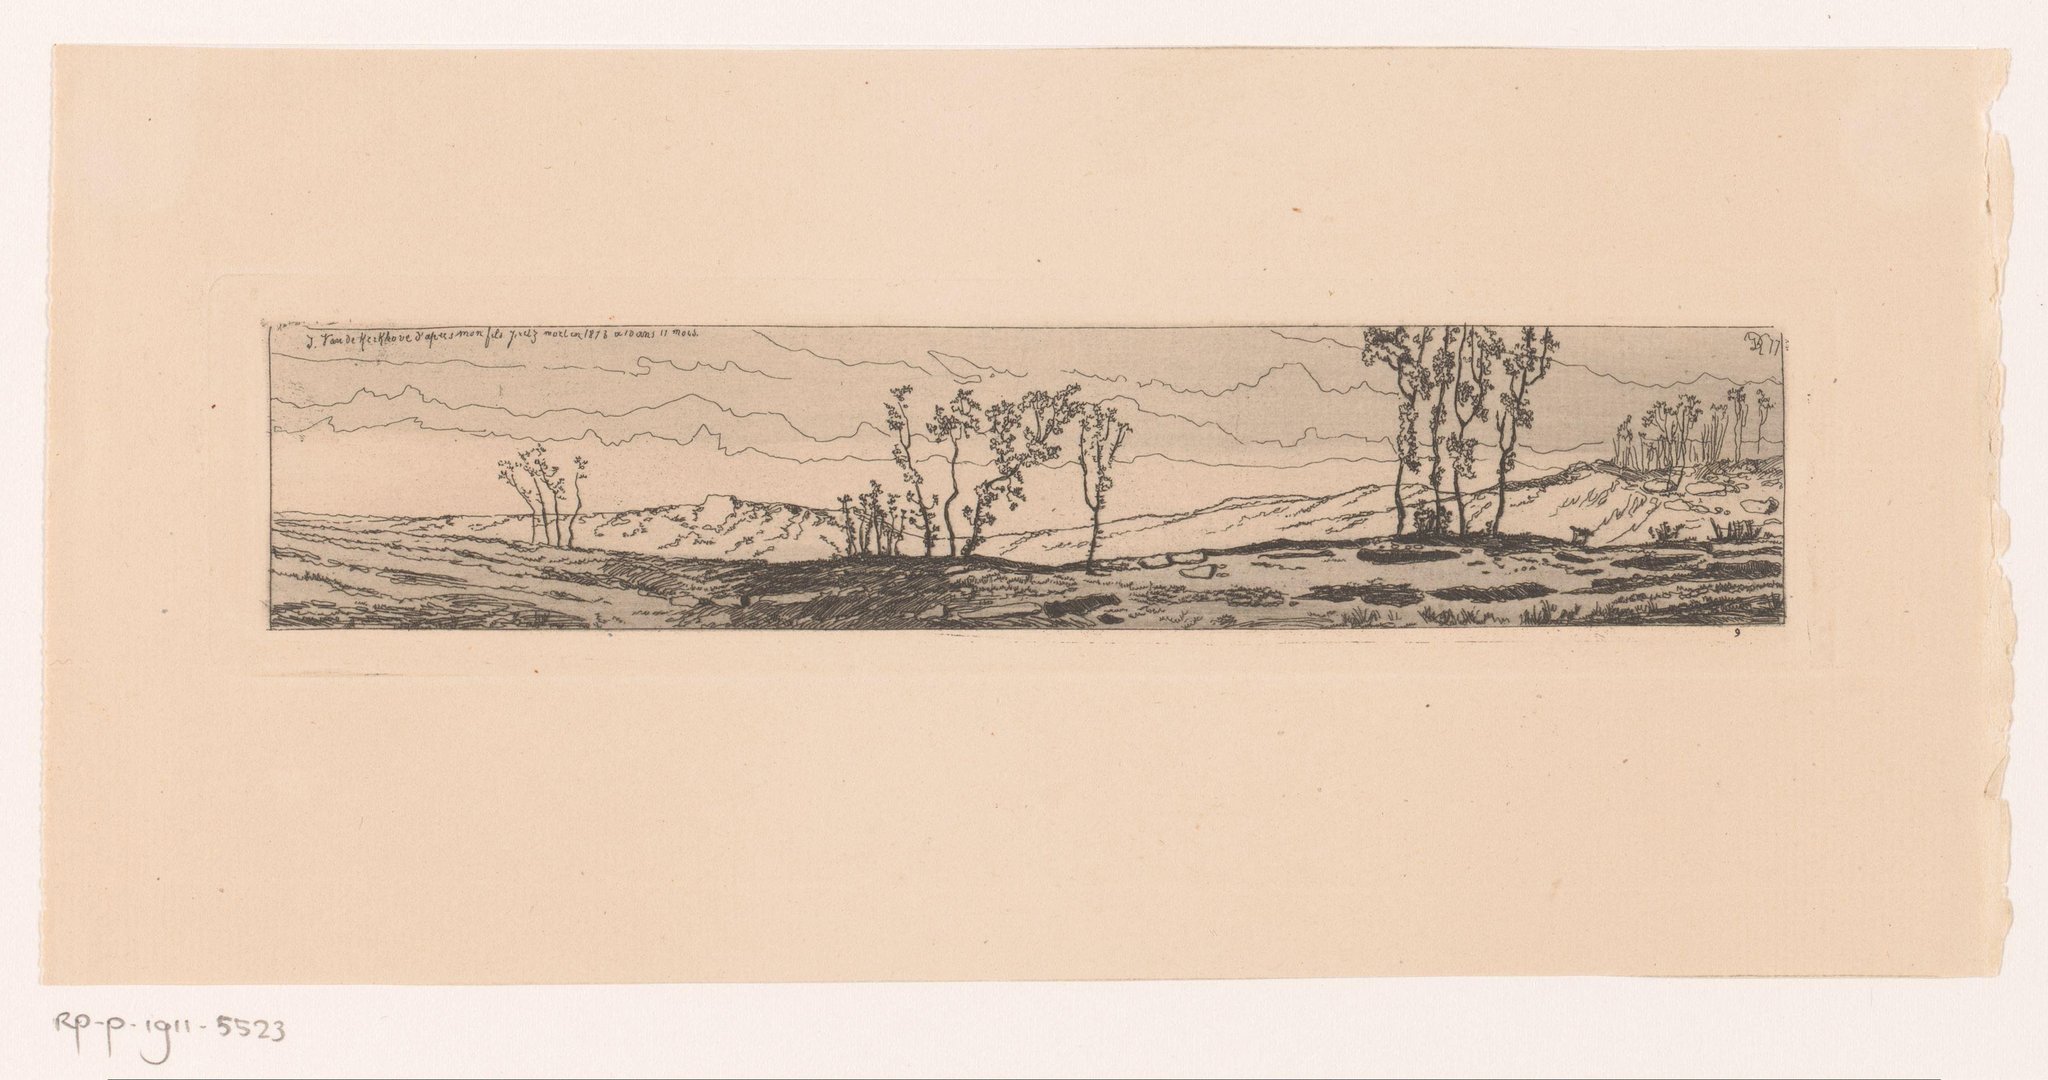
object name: print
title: Heuvelachtig landschap met groepen bomen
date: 1877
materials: paper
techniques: etching, intaglio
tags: low hill country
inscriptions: collector's mark: Lugt 2228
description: De etsen naar de schilderijen van Frédéric Van de Kerkhove werden na zijn dood door zijn vader en zuster gemaakt en uitgegeven in twee reeksen. De eerste werd in 1877 uitgegeven door het Journal des Beaux-Arts et de la Littérature: Cahier de 25 Eaux-fortes d'après Frédéric van de Kerkhove, gravées par son père et sa sœur. De tweede reeks van 126 etsen, ook in 1877, werd in Parijs uitgegeven bij A. Lévy onder de titel Cent eaux-fortes gravées par J. Van de Kerkhove d'après les tableaux de Frédéric Van de Kerkhove, mort en 1873 à l'âge de 10 ans et 11 mois.